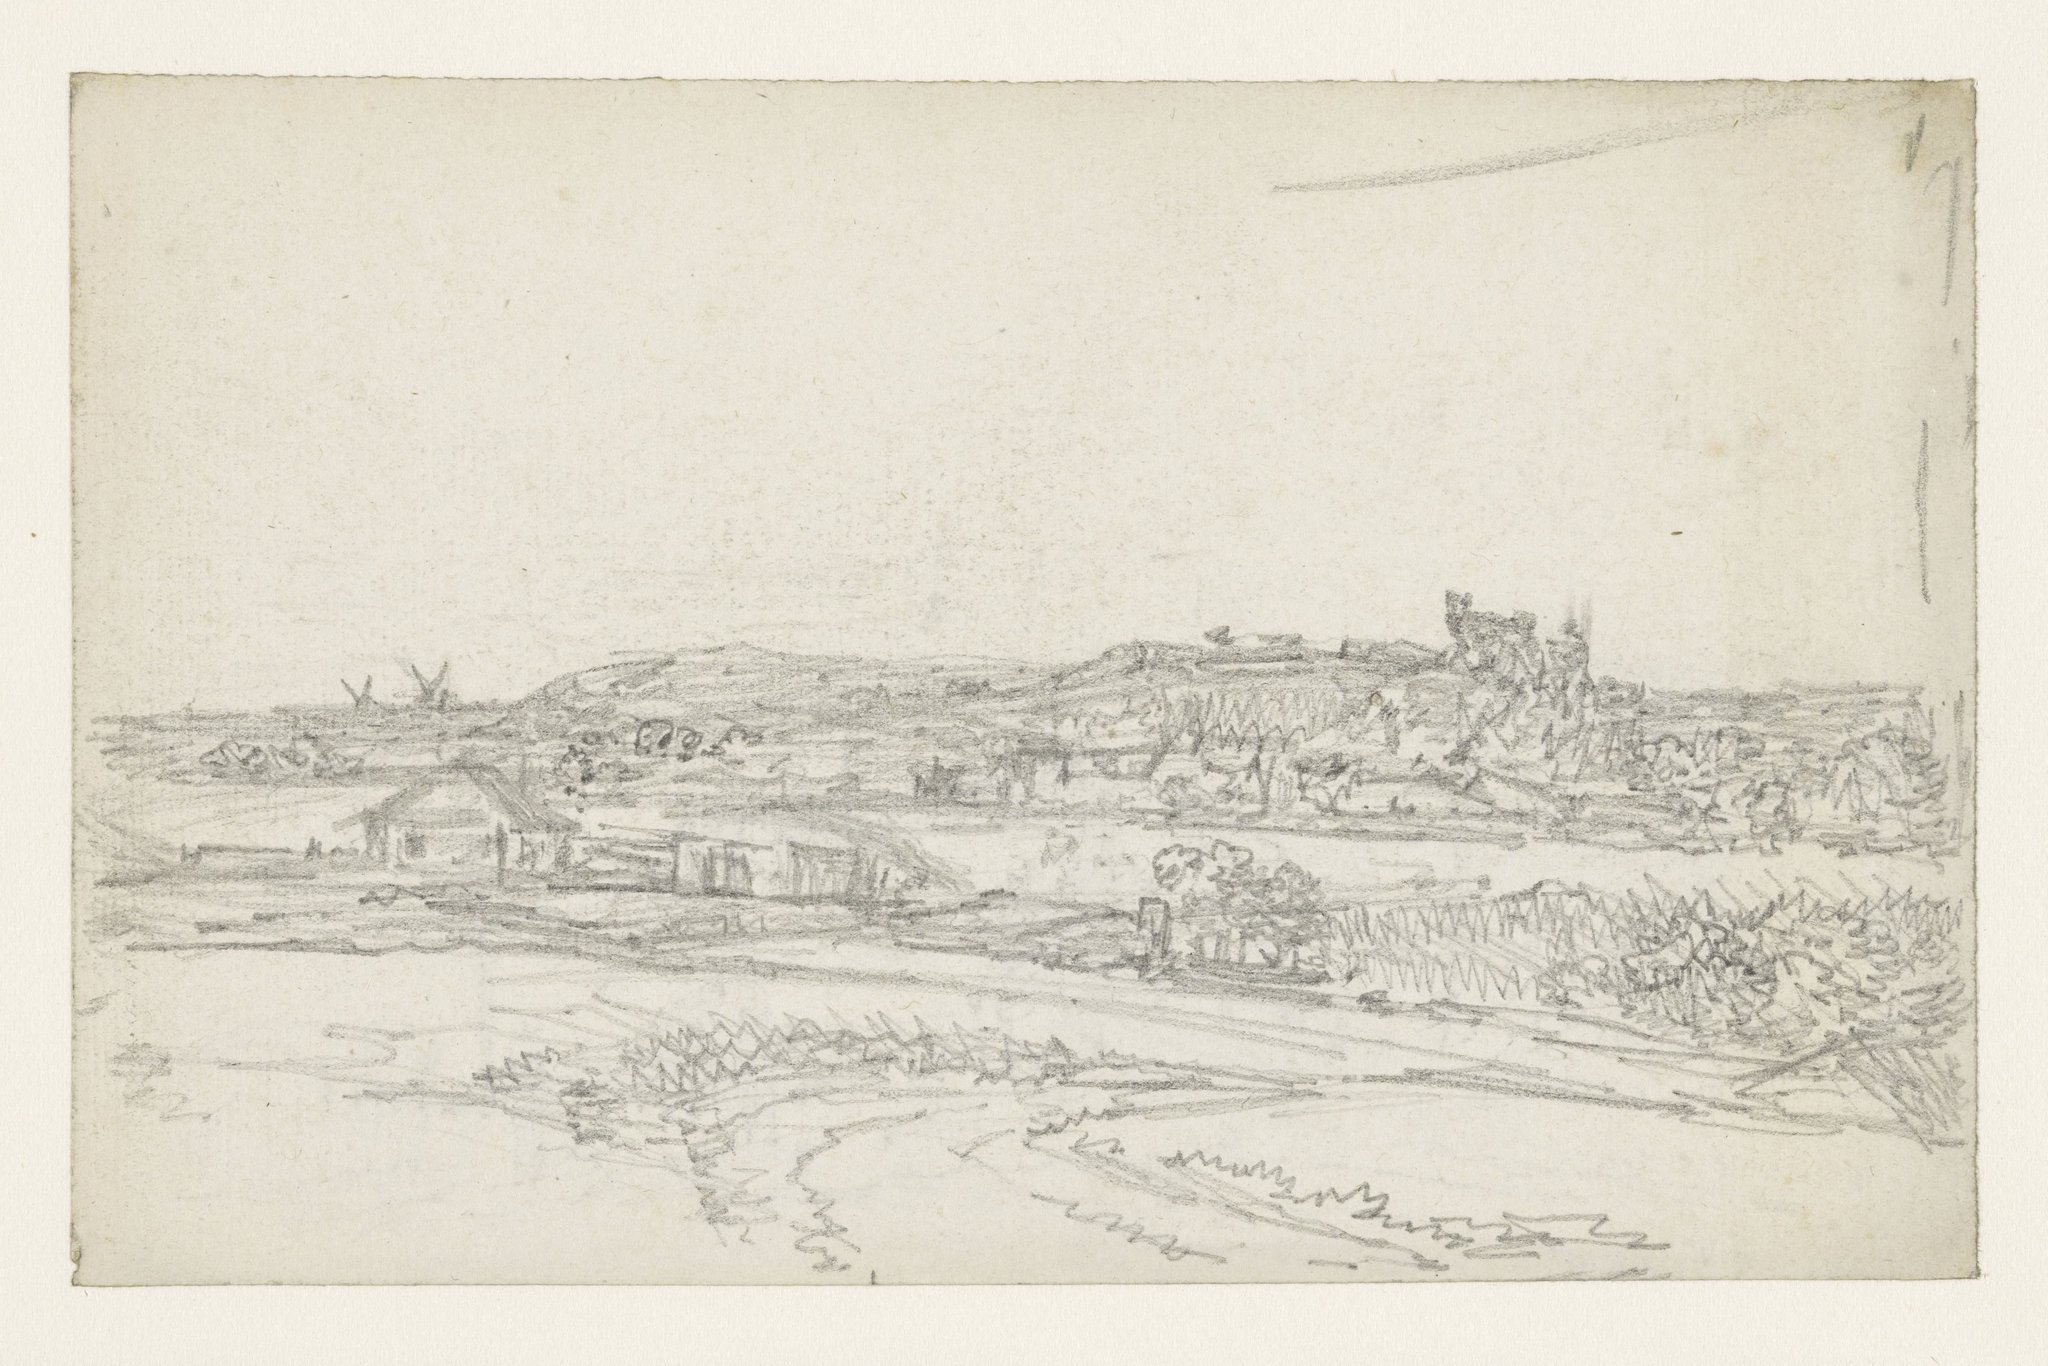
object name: drawing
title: Montmartre gezien uit de vlakte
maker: georges michel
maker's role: draughtsman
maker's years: 1763-1843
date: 1773-1843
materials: paper, pencil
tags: street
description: Een van 120 tekeningen, afkomstig uit een 19e eeuws album met tekeningen van Georges Michel.